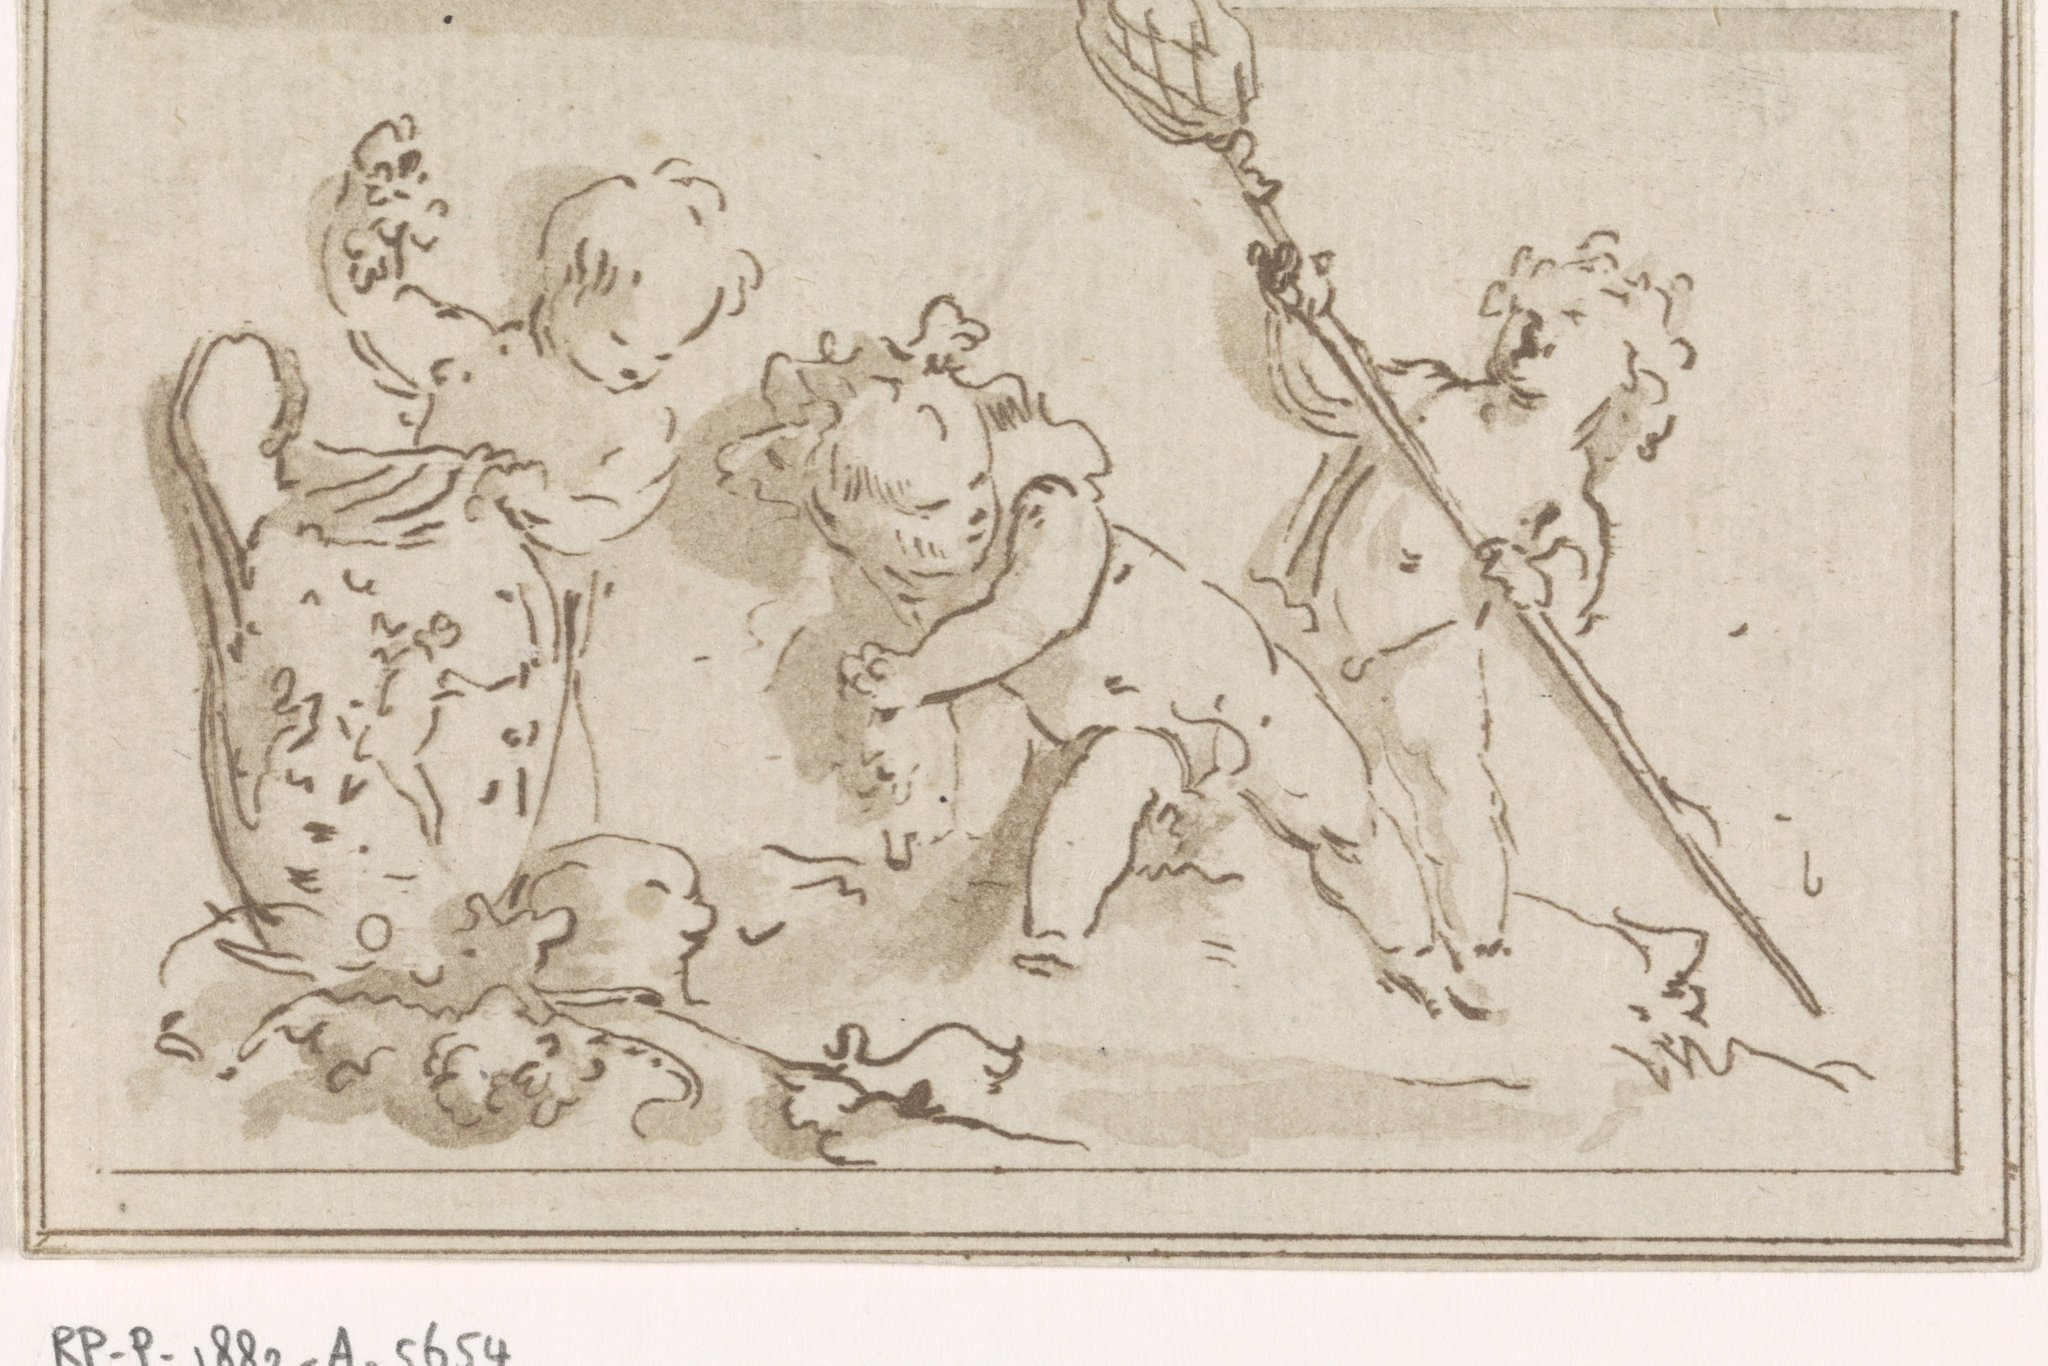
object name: print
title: Drie putti bij een vaas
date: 1784-1826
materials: paper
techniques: aquatint, etching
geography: amsterdam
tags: vase ~ ornament, cupids: 'amores', 'amoretti', 'putti'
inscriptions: collector's mark: Lugt 2228